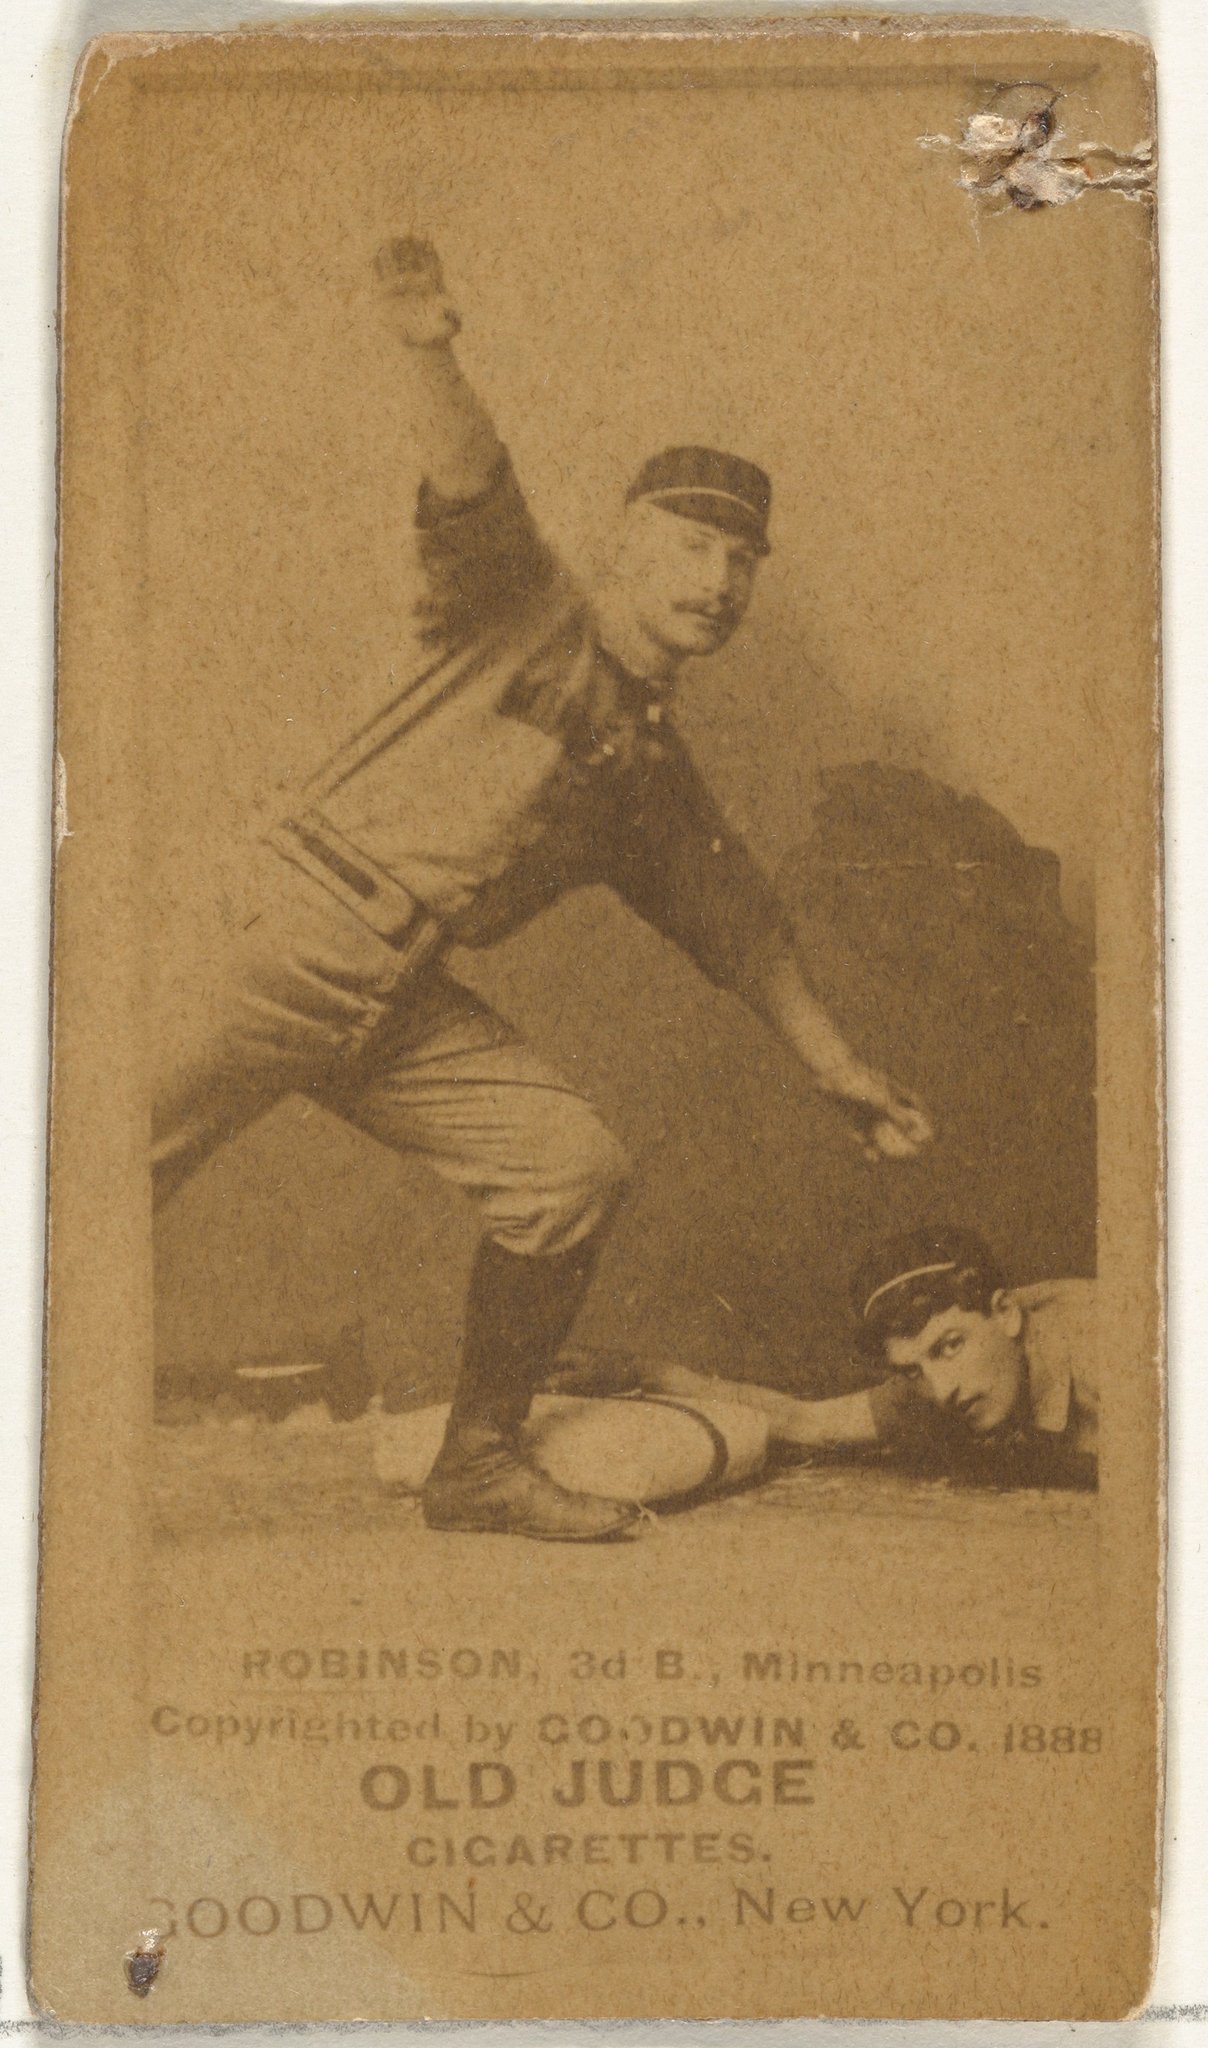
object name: baseball card, photograph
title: Myers C. Robinson, 3rd Base, Minneapolis, from the Old Judge series (N172) for Old Judge Cigarettes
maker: goodwin & company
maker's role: publisher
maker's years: 1850-1950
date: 1888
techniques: albumen silver print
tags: men,portraits,baseball,athletes